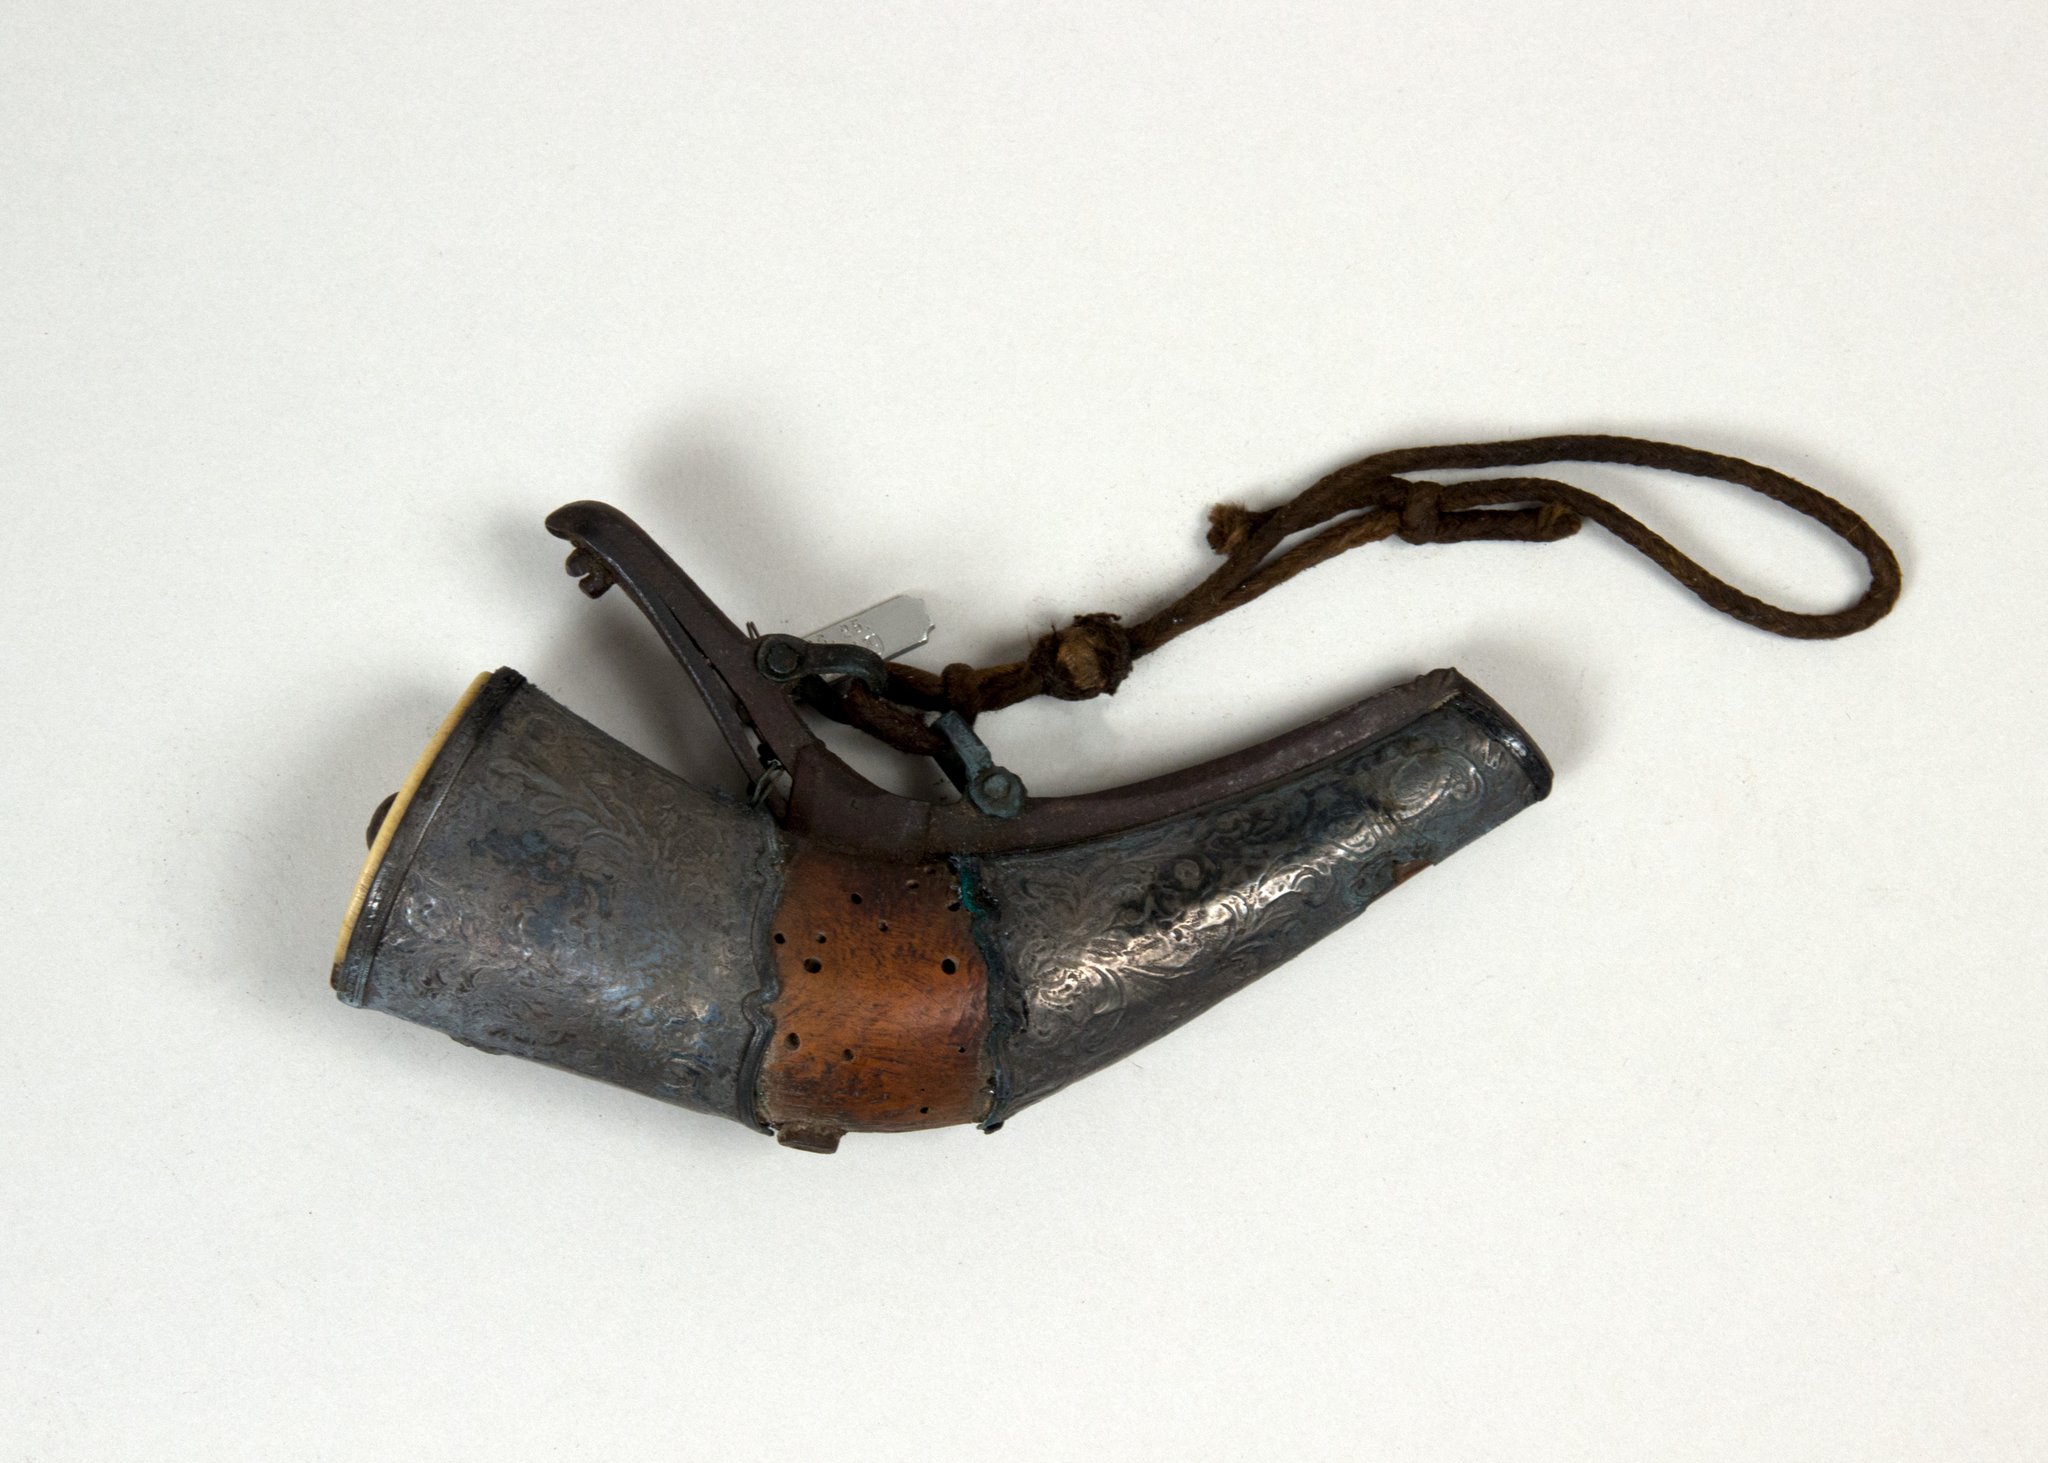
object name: primer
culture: turkish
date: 1701-1800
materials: horn, silver, wood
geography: ottoman empire